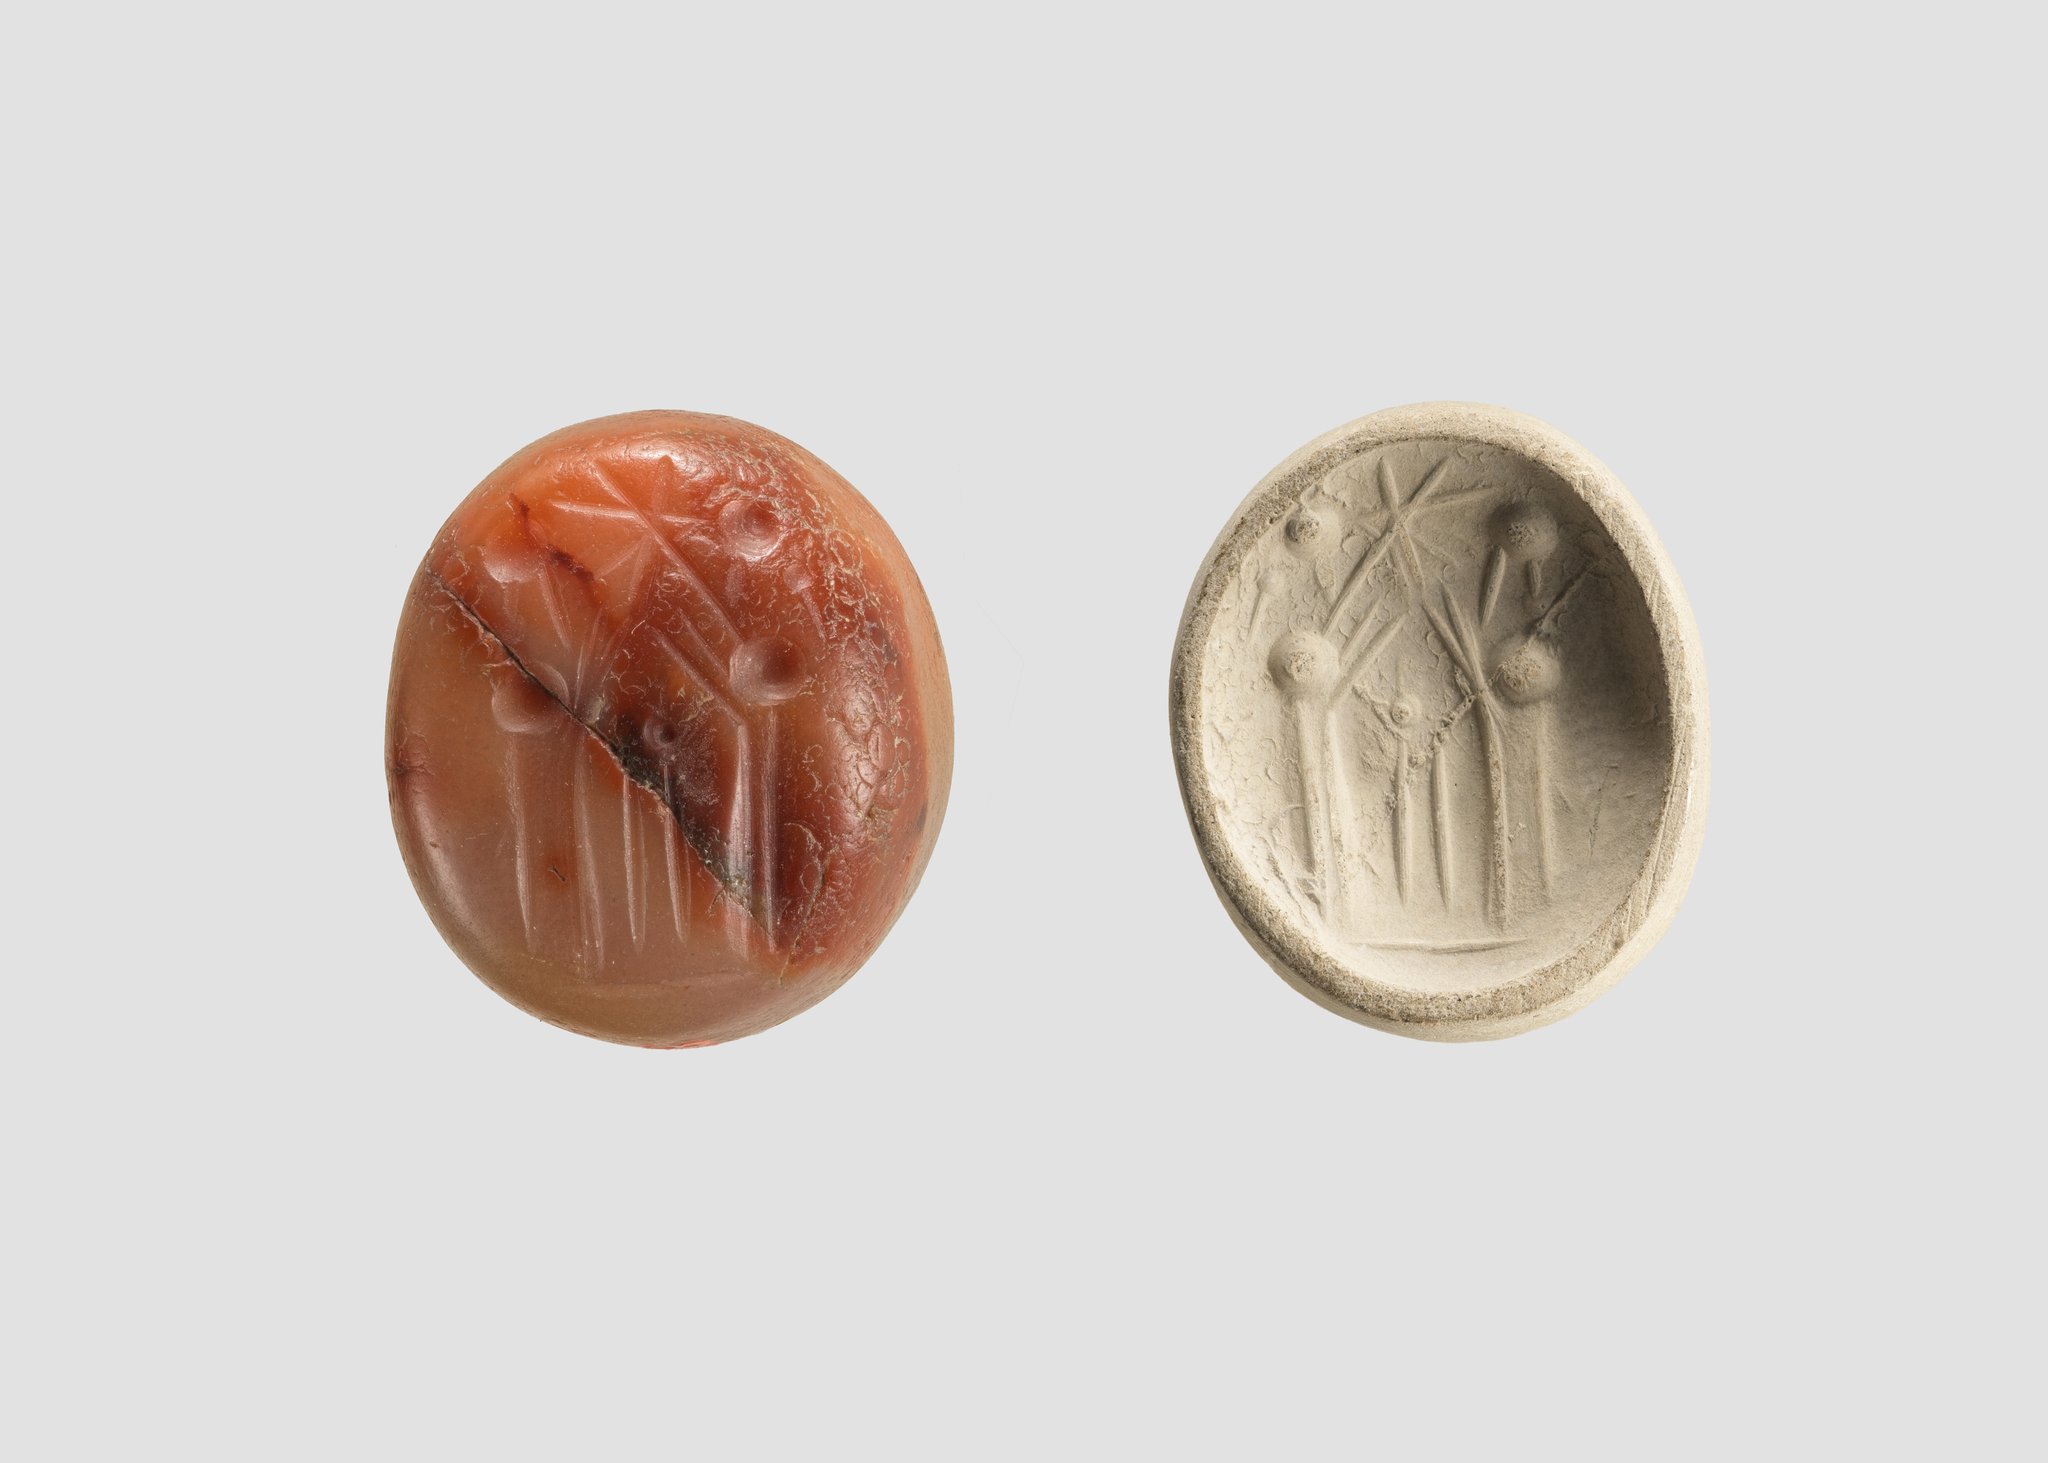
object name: stamp seal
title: Stamp seal (oval conoid) with cultic scene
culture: assyro-babylonian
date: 700-501 BCE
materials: stone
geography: mesopotamia